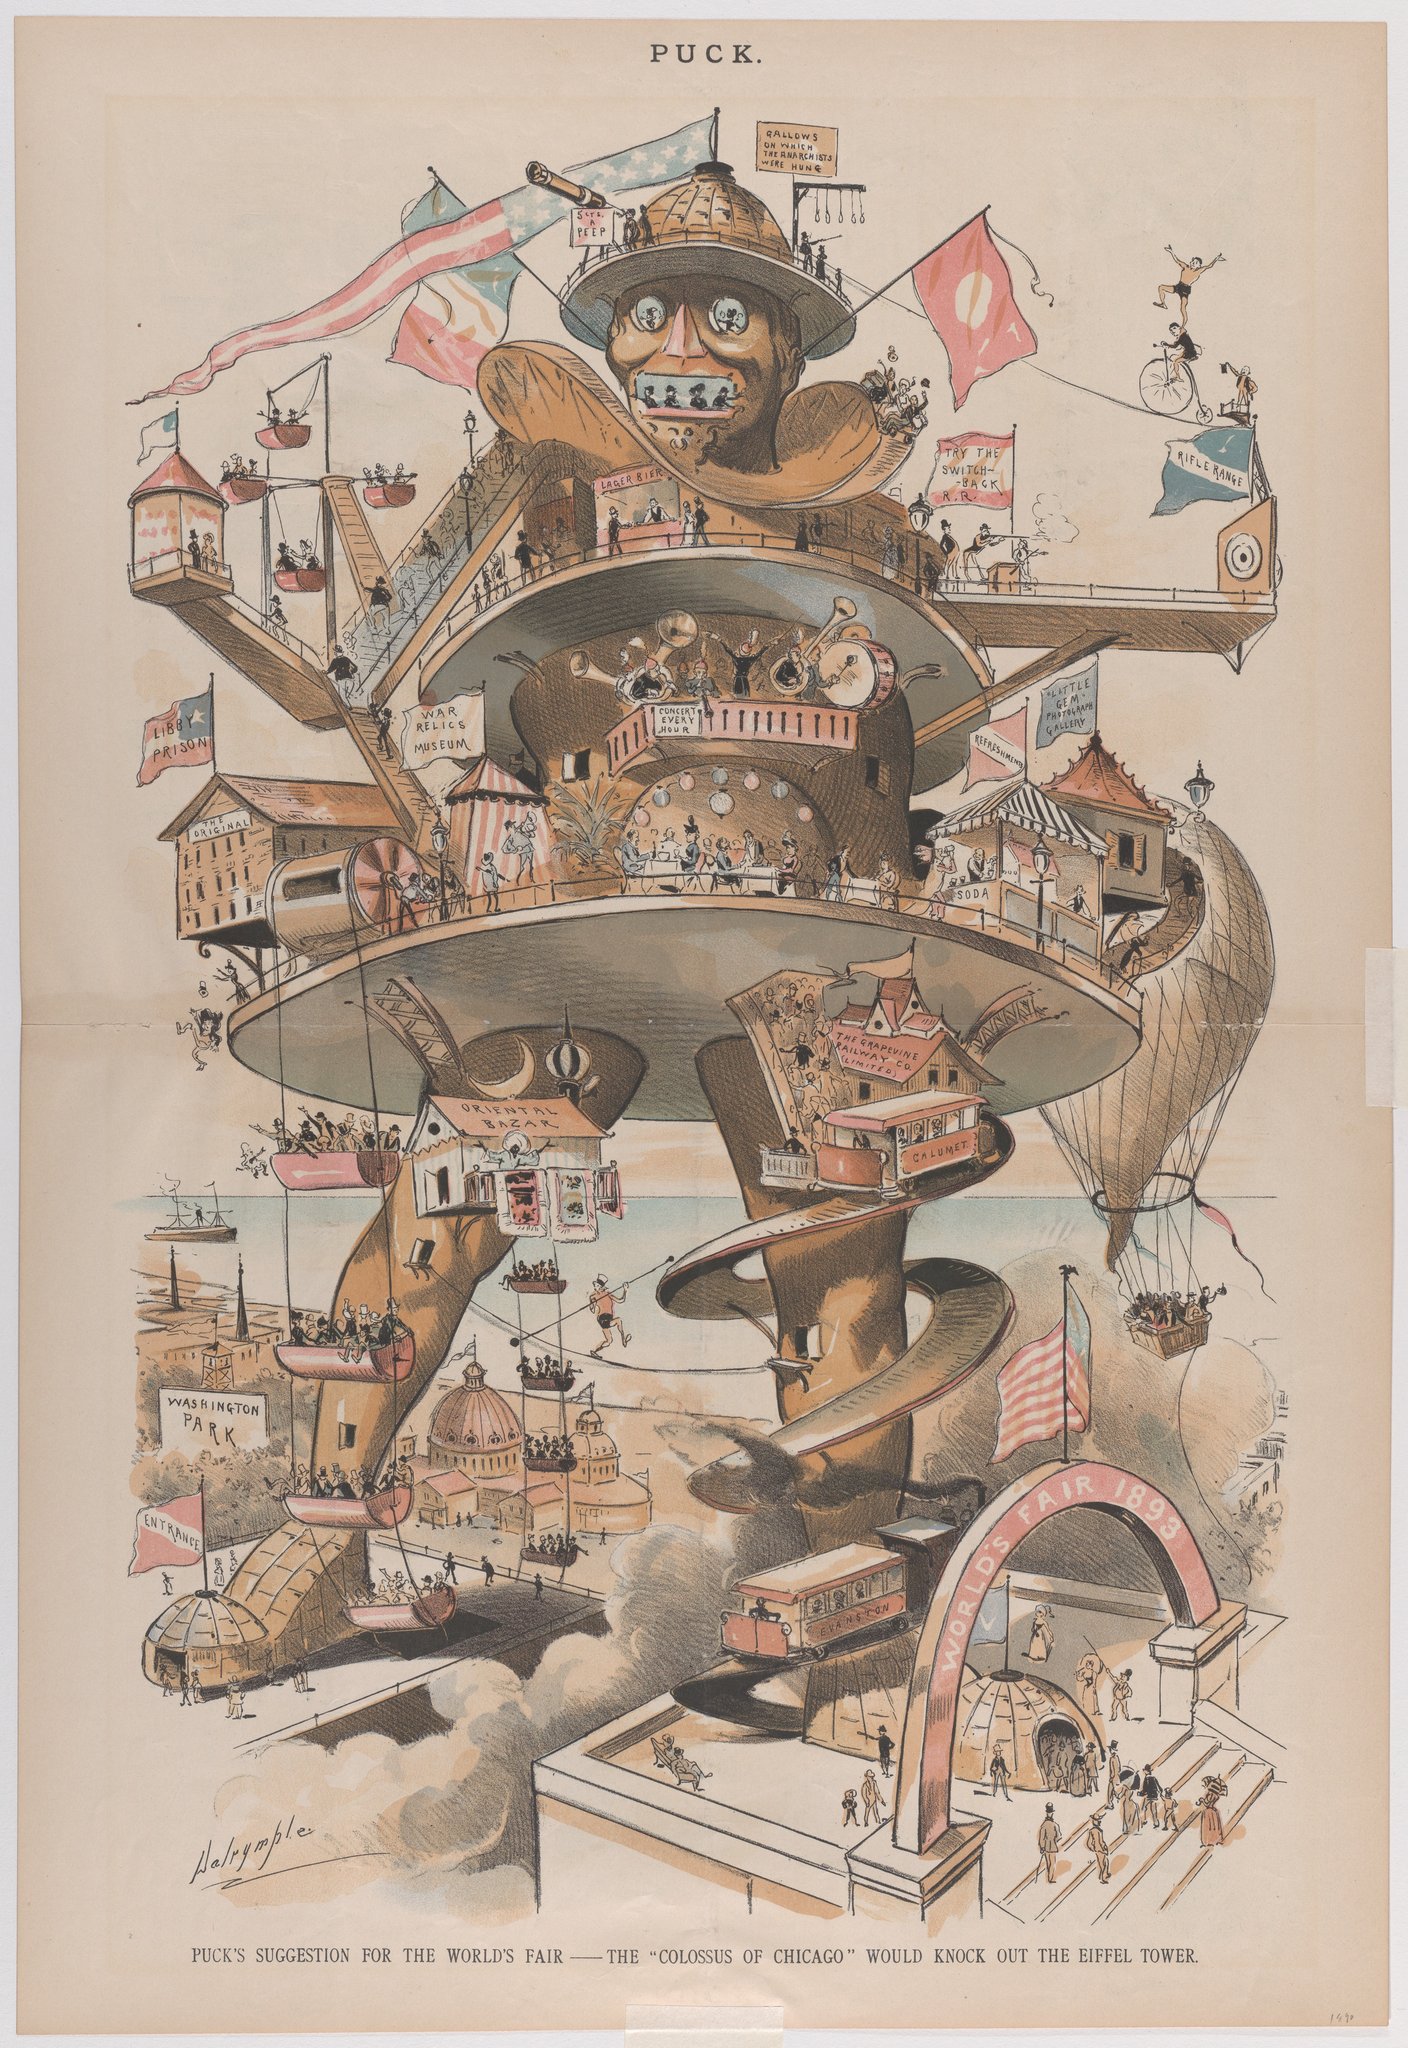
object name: print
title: Puck's Suggestion for the World's Fair, The Colossus of Chicago Would Knock Out the Eiffel Tower, from "Puck Magazine"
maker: louis dalrymple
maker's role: artist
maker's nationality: american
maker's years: 1866-1905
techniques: lithograph